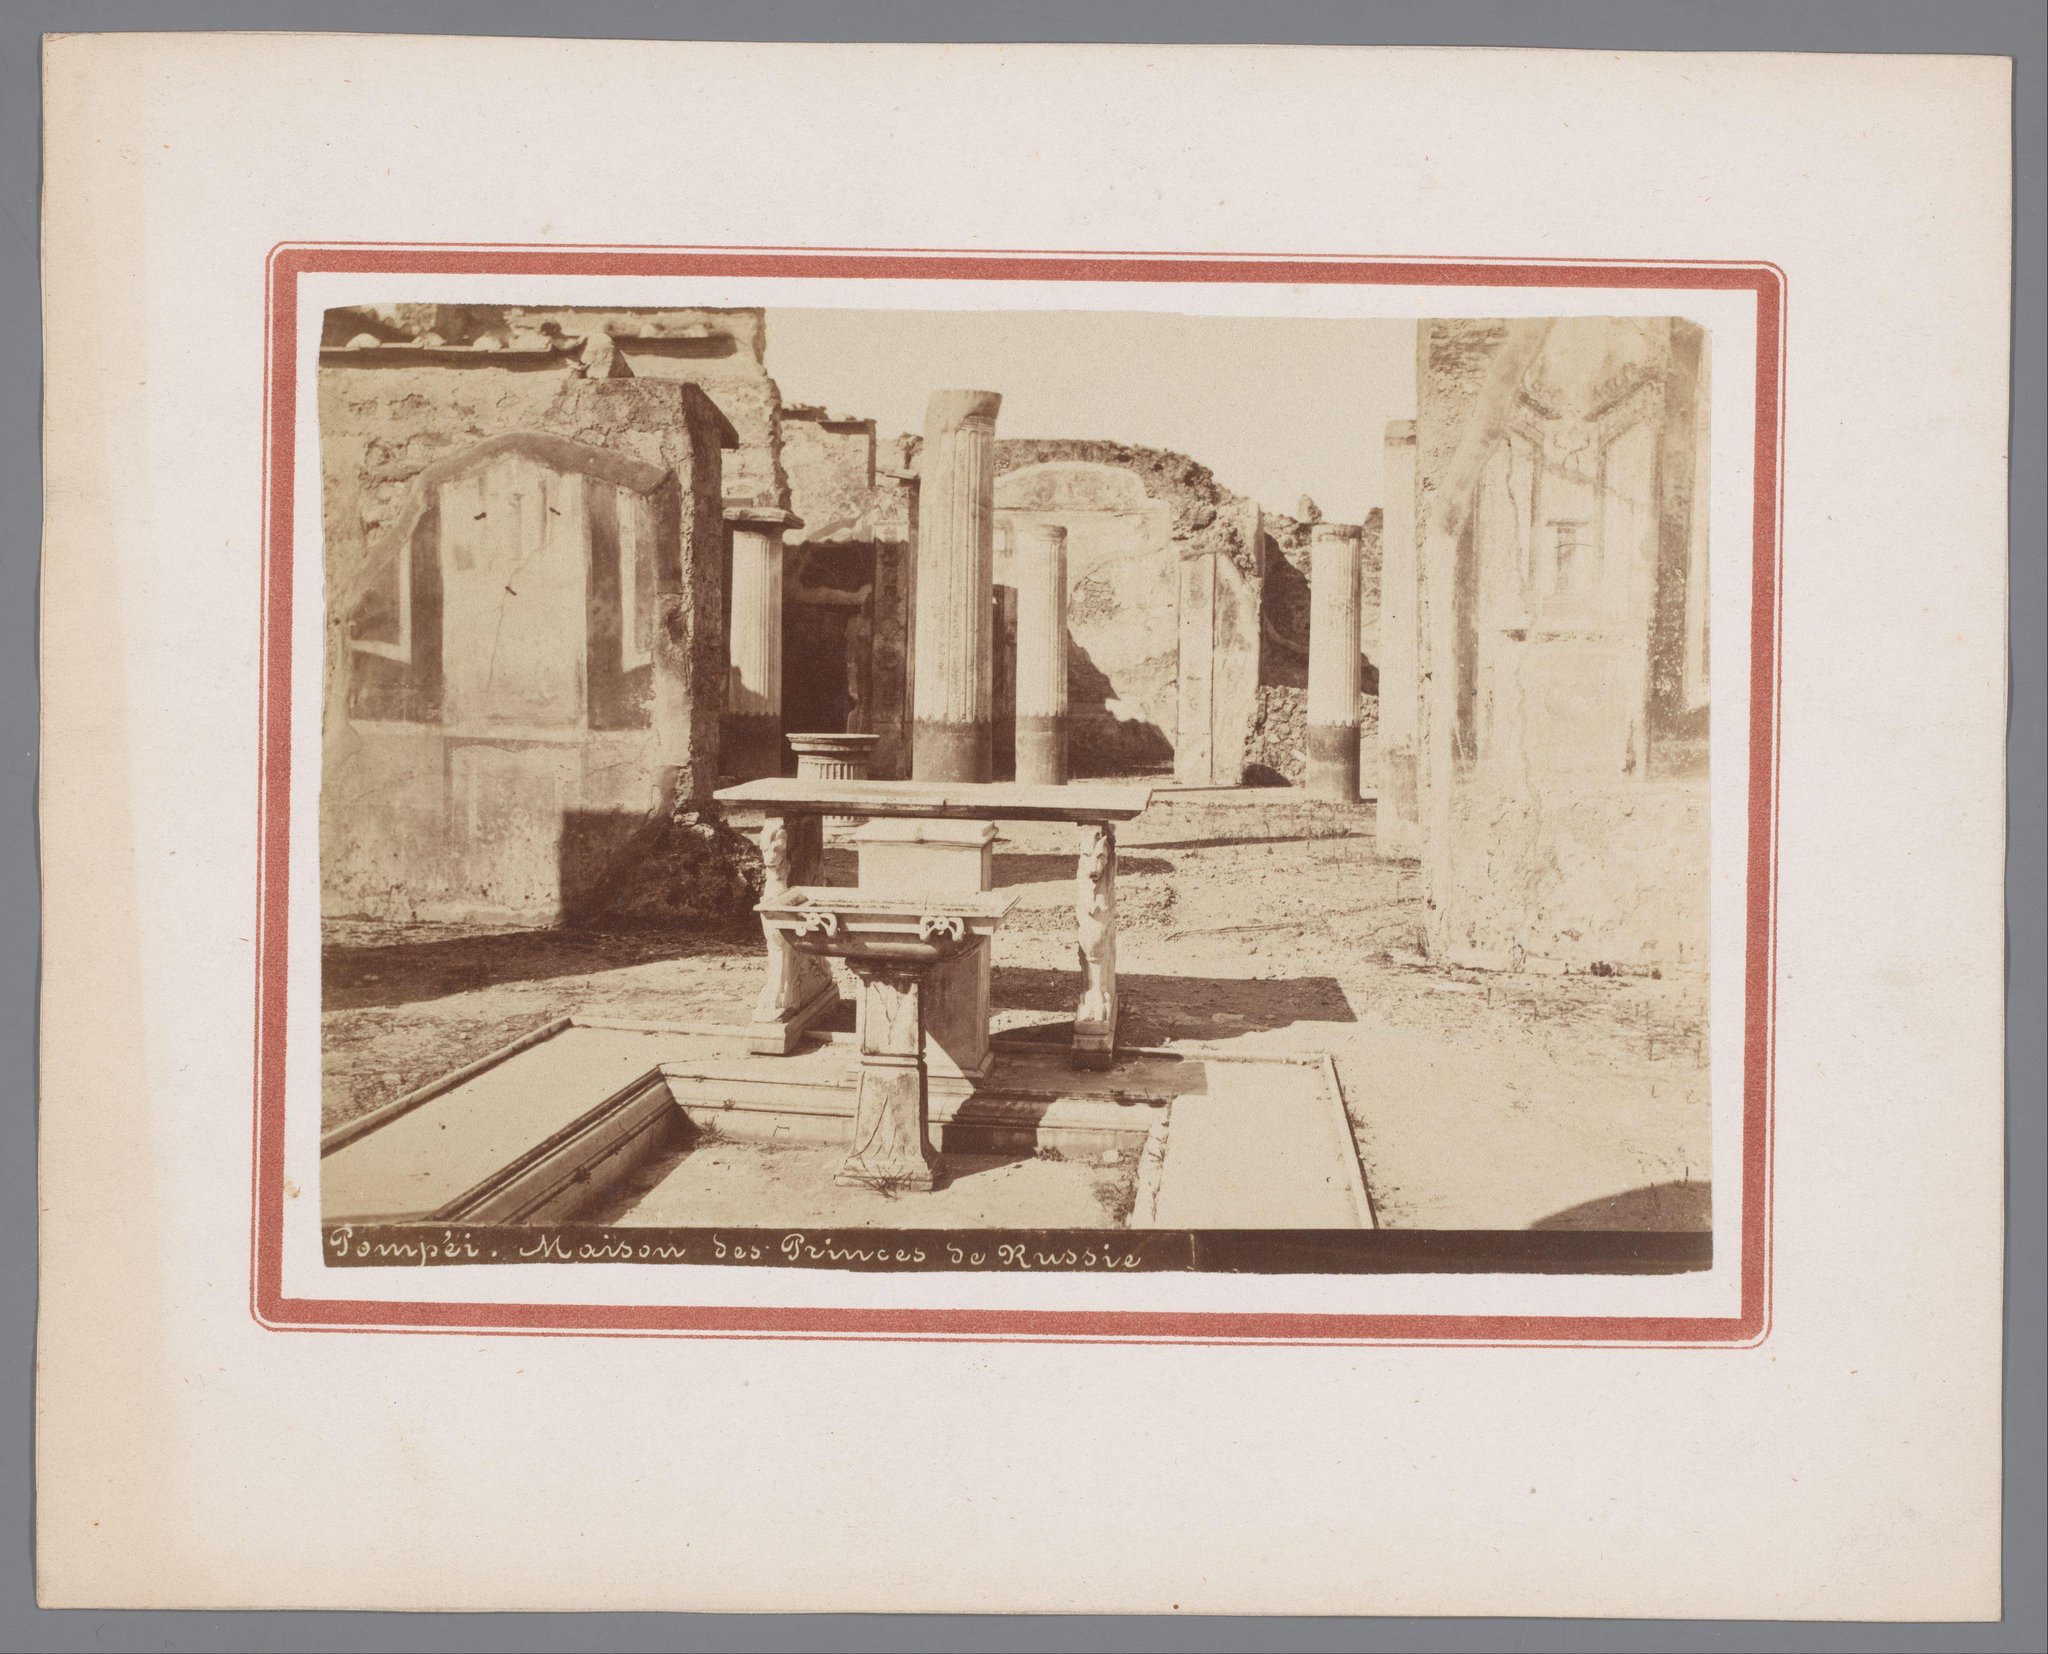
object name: photograph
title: Pompéi. Maison des Princes de Russie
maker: giorgio sommer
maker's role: fotograaf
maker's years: 1834-1914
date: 1857-1914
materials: cardboard, paper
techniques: albumen print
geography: pompeii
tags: urban housing, ruin of a building ~ architecture, pompeii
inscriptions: inscription: ‘10’, collector's mark: ‘VOSMAER’